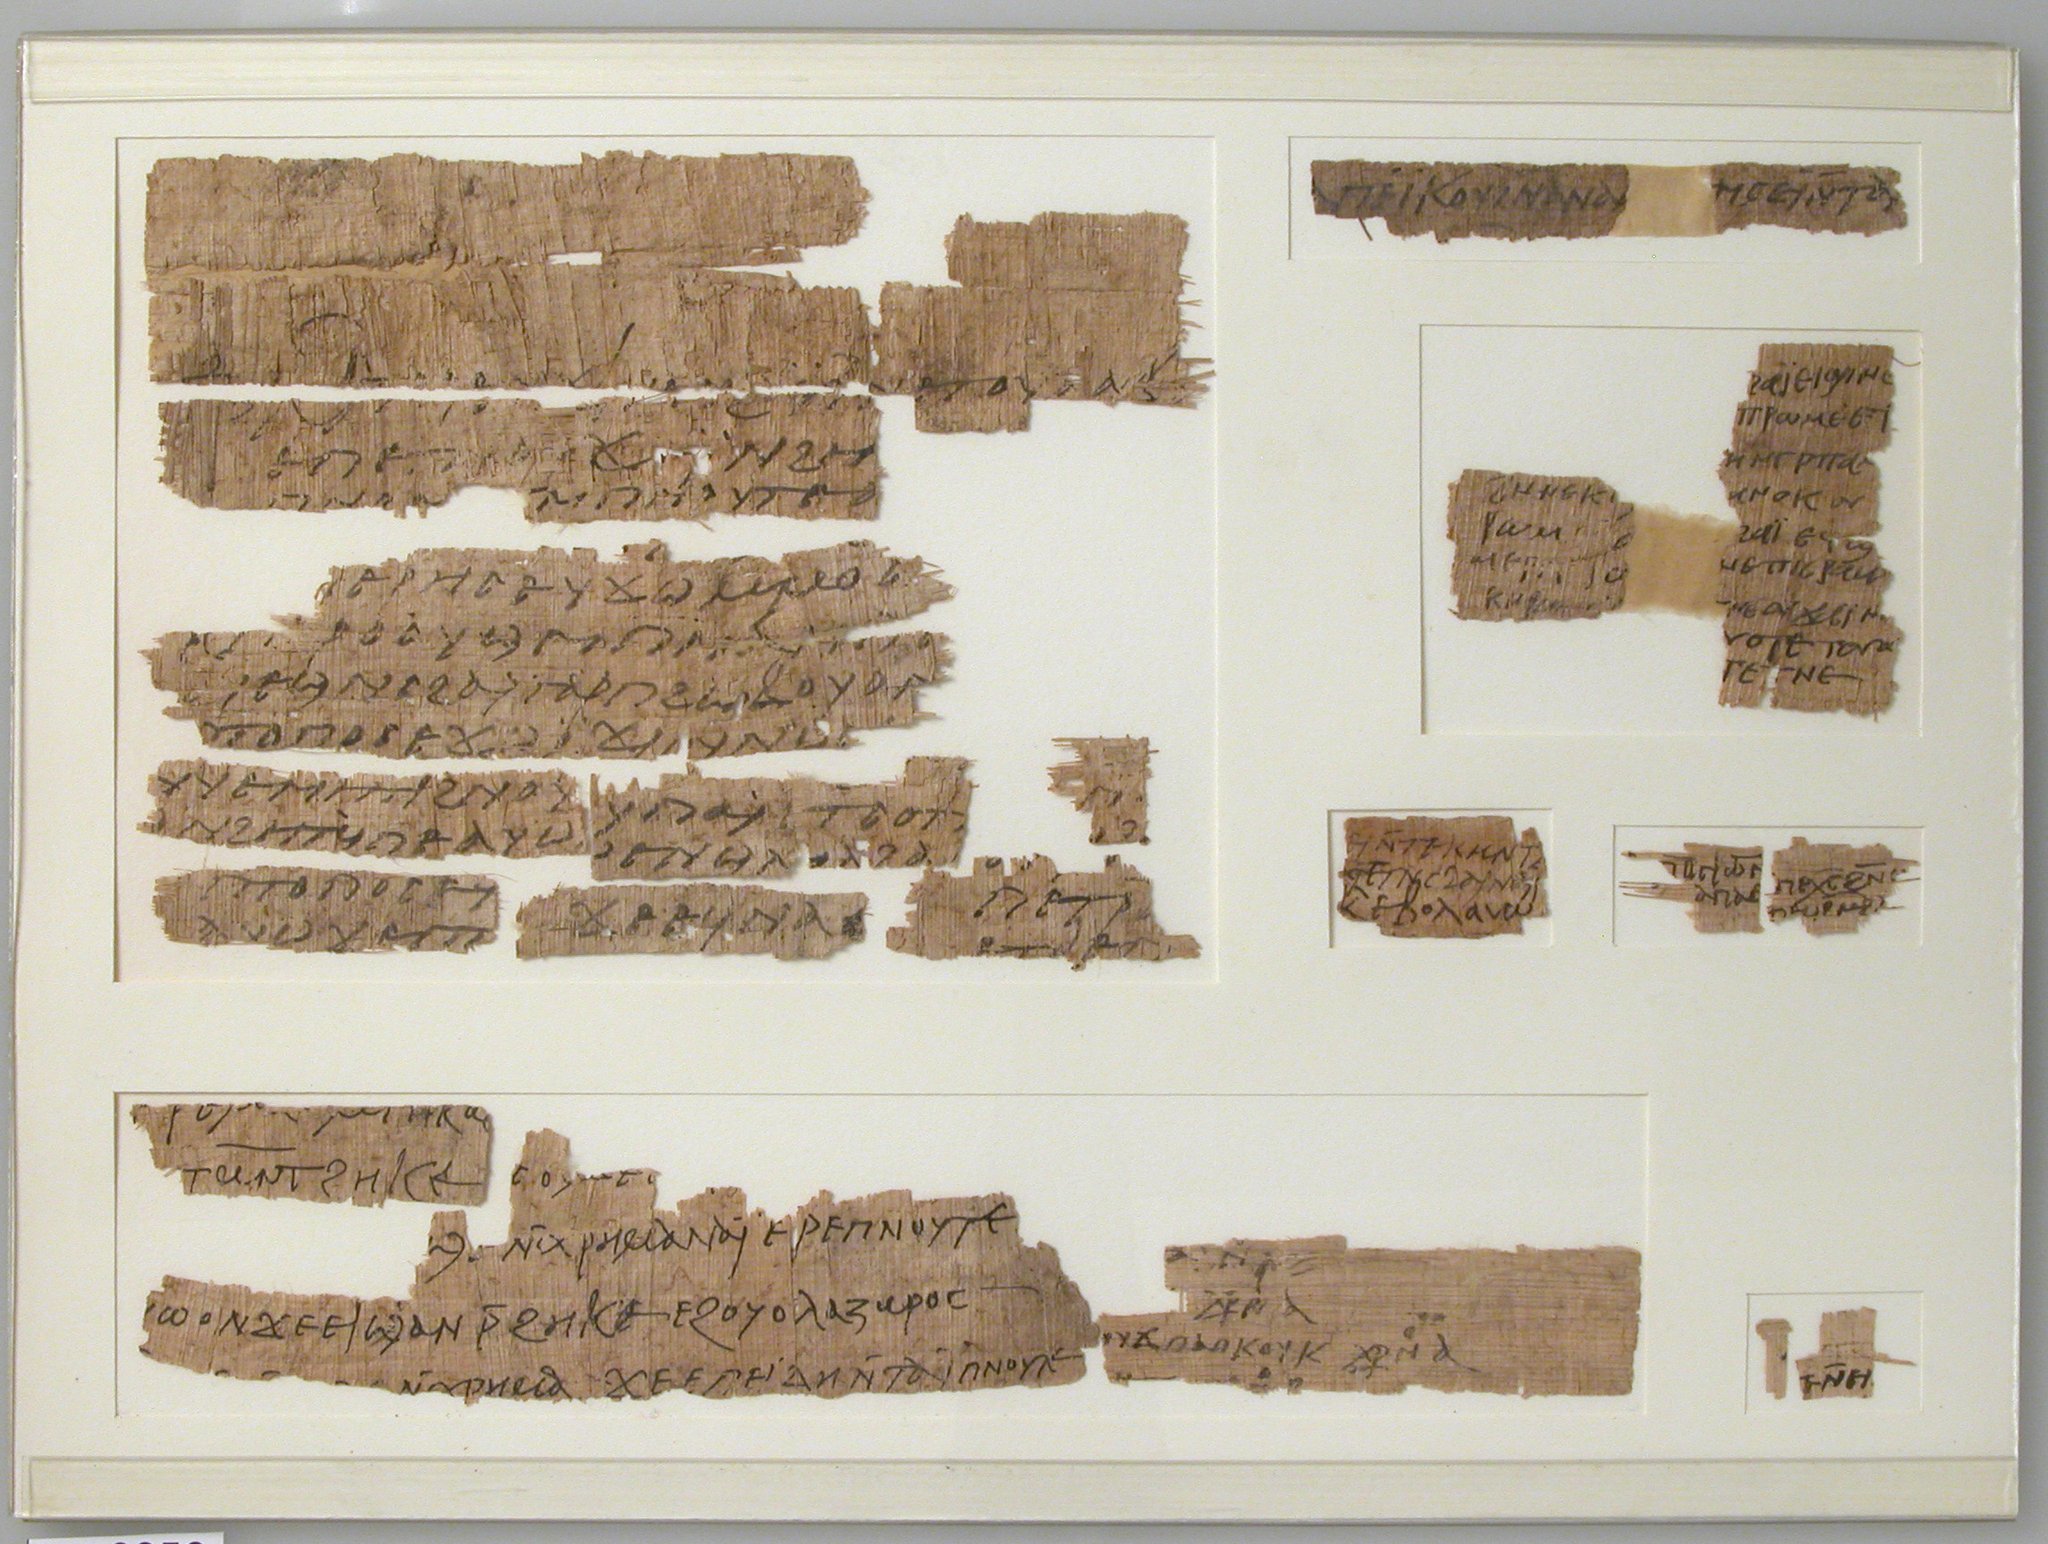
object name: fragment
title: Papyri Fragments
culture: coptic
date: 601-700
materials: ink, papyrus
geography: egypt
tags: documents